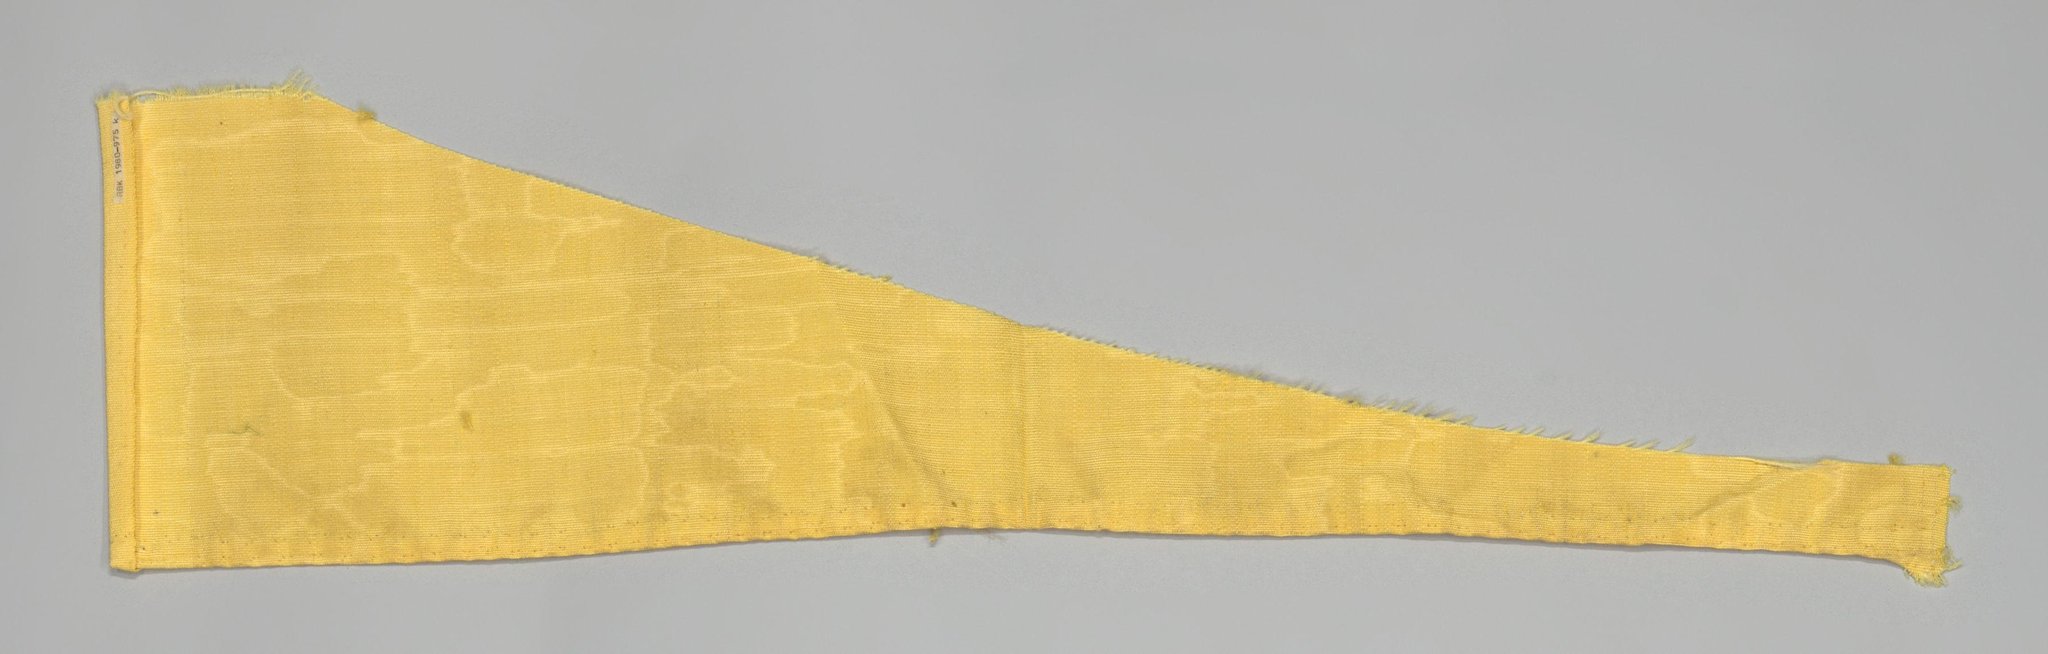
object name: bed covering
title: Fragment van een bedgarnituur van gele gewaterde wol met groen passement en afhangende klosjes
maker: Anonymous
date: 1795-1815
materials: wool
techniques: moire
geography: northern netherlands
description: Fragment van een bedgarnituur van gele gewaterde wol, omboord met groen passement met een geel motief en met een groen en geel boordsel met afhangende klosjes die met gele en groene zijde zijn omwonden.